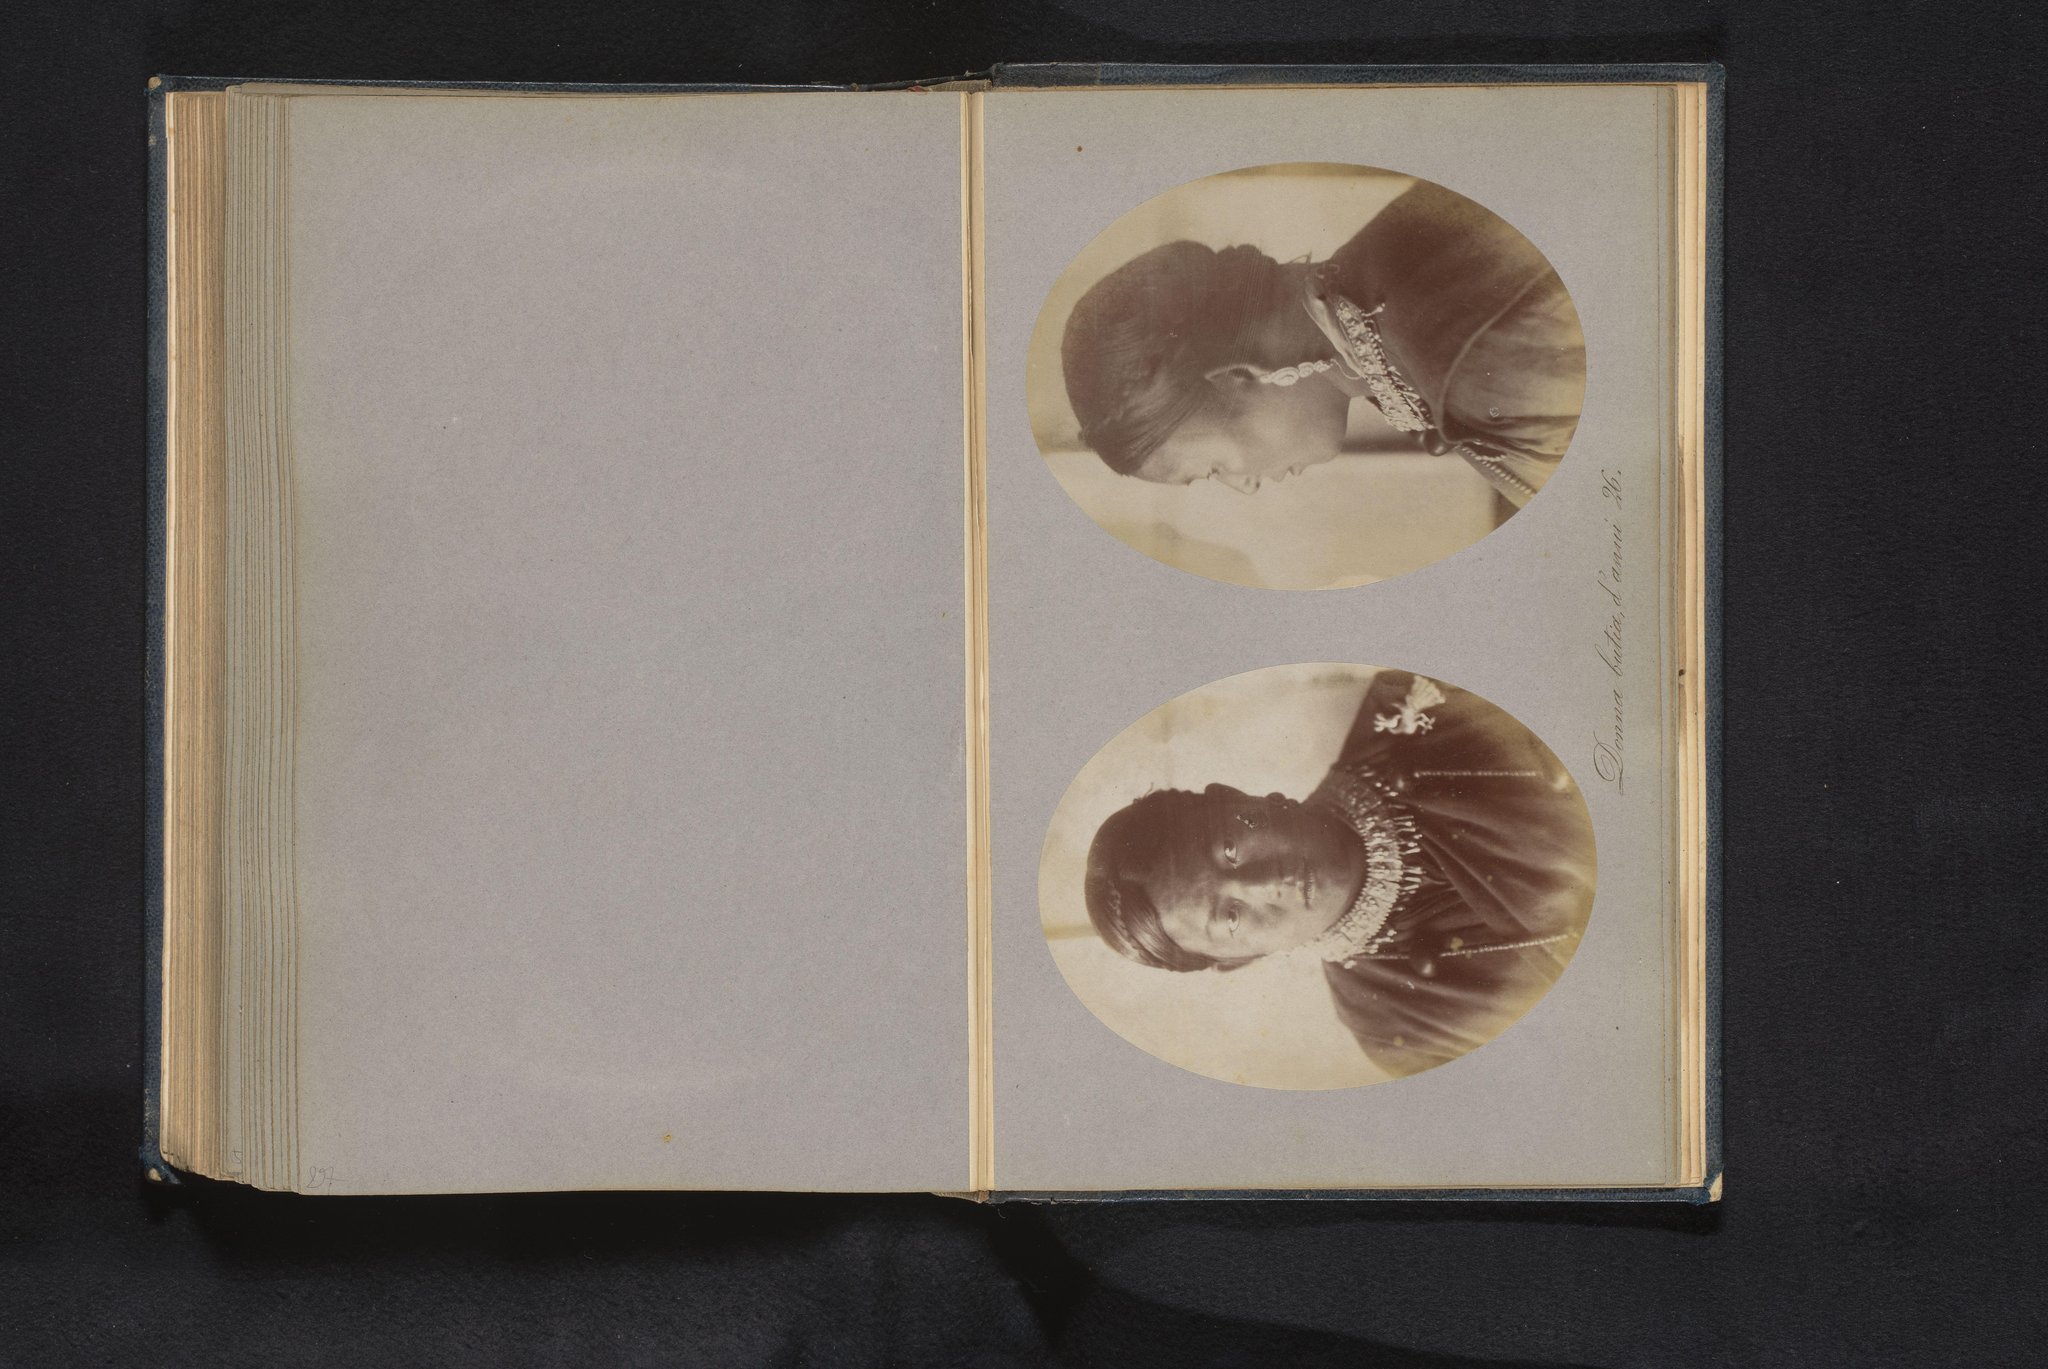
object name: photograph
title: Donna butia, d'anni 26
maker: paolo mantegazza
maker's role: antropoloog, professor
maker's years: 1831-1910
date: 1881-1886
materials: photographic support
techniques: albumen print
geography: bhutan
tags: adult woman (+ sideview, profile), adult woman (+ front view)